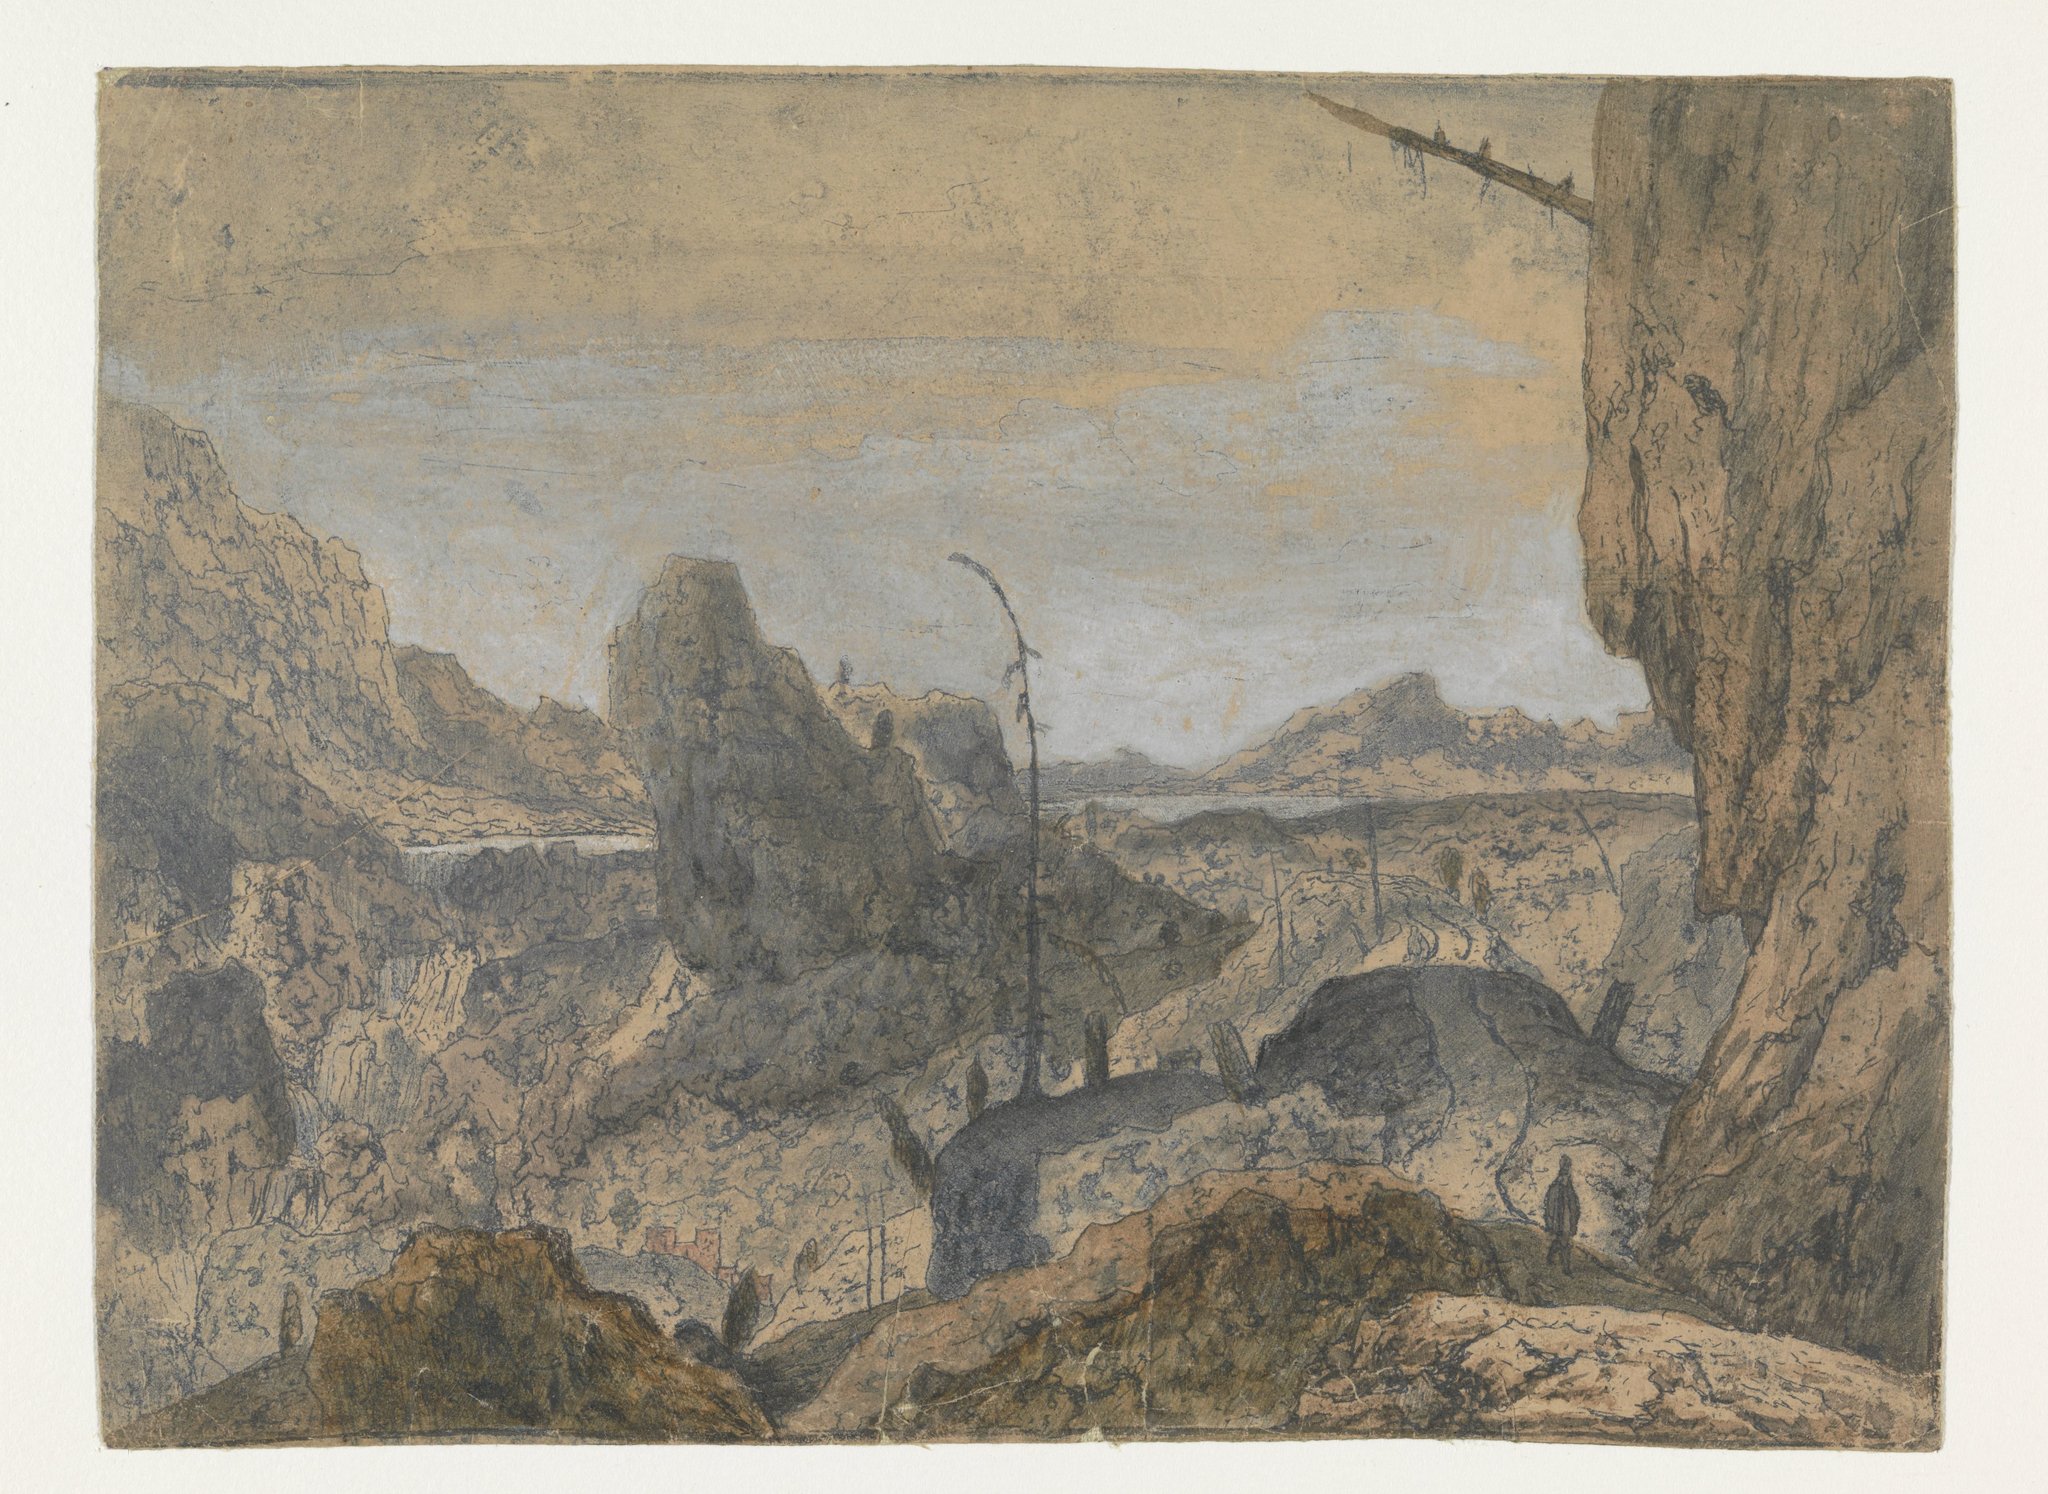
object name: print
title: Rocky Landscape with a Man Walking to the Right: First Version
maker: hercules segers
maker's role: draughtsman, painter, print maker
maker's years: 1589-1640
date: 1625-1630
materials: paint, linen, paper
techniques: brush, drypoint, etching, hand coloring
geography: amsterdam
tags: walking, hiking (recreation), rocks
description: Eerste versie van het rotsachtige landschap met een wandelaar.